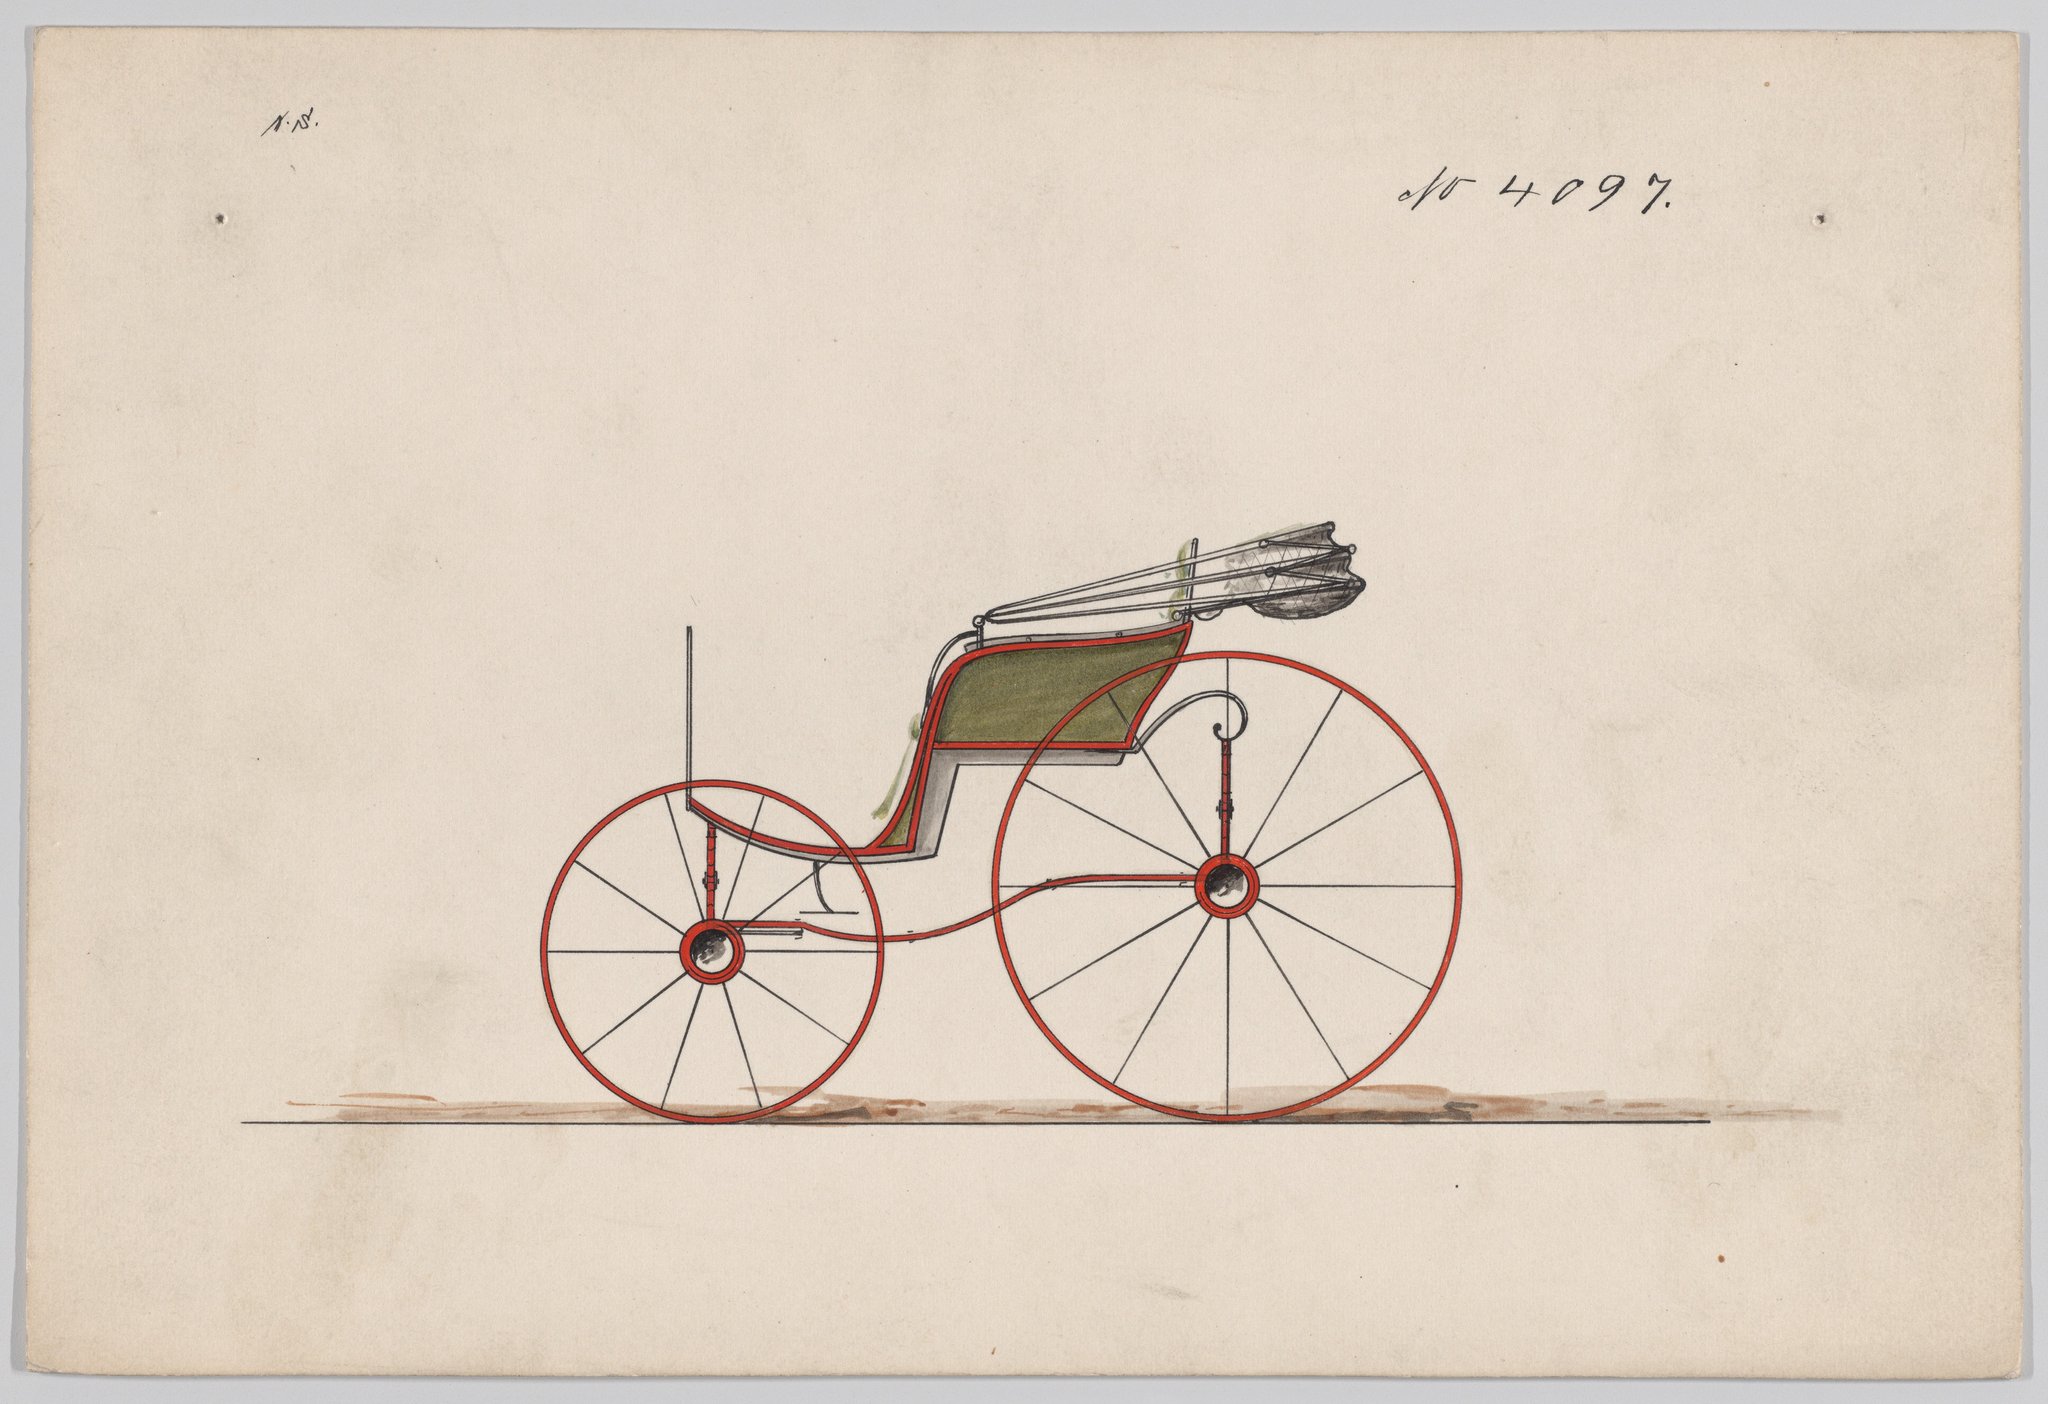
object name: drawing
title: Design for Pony Phaeton, no. 4097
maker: brewster & co.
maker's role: manufacturer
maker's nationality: american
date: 1890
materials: gouache, gum arabic, ink, watercolor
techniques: pen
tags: carriages